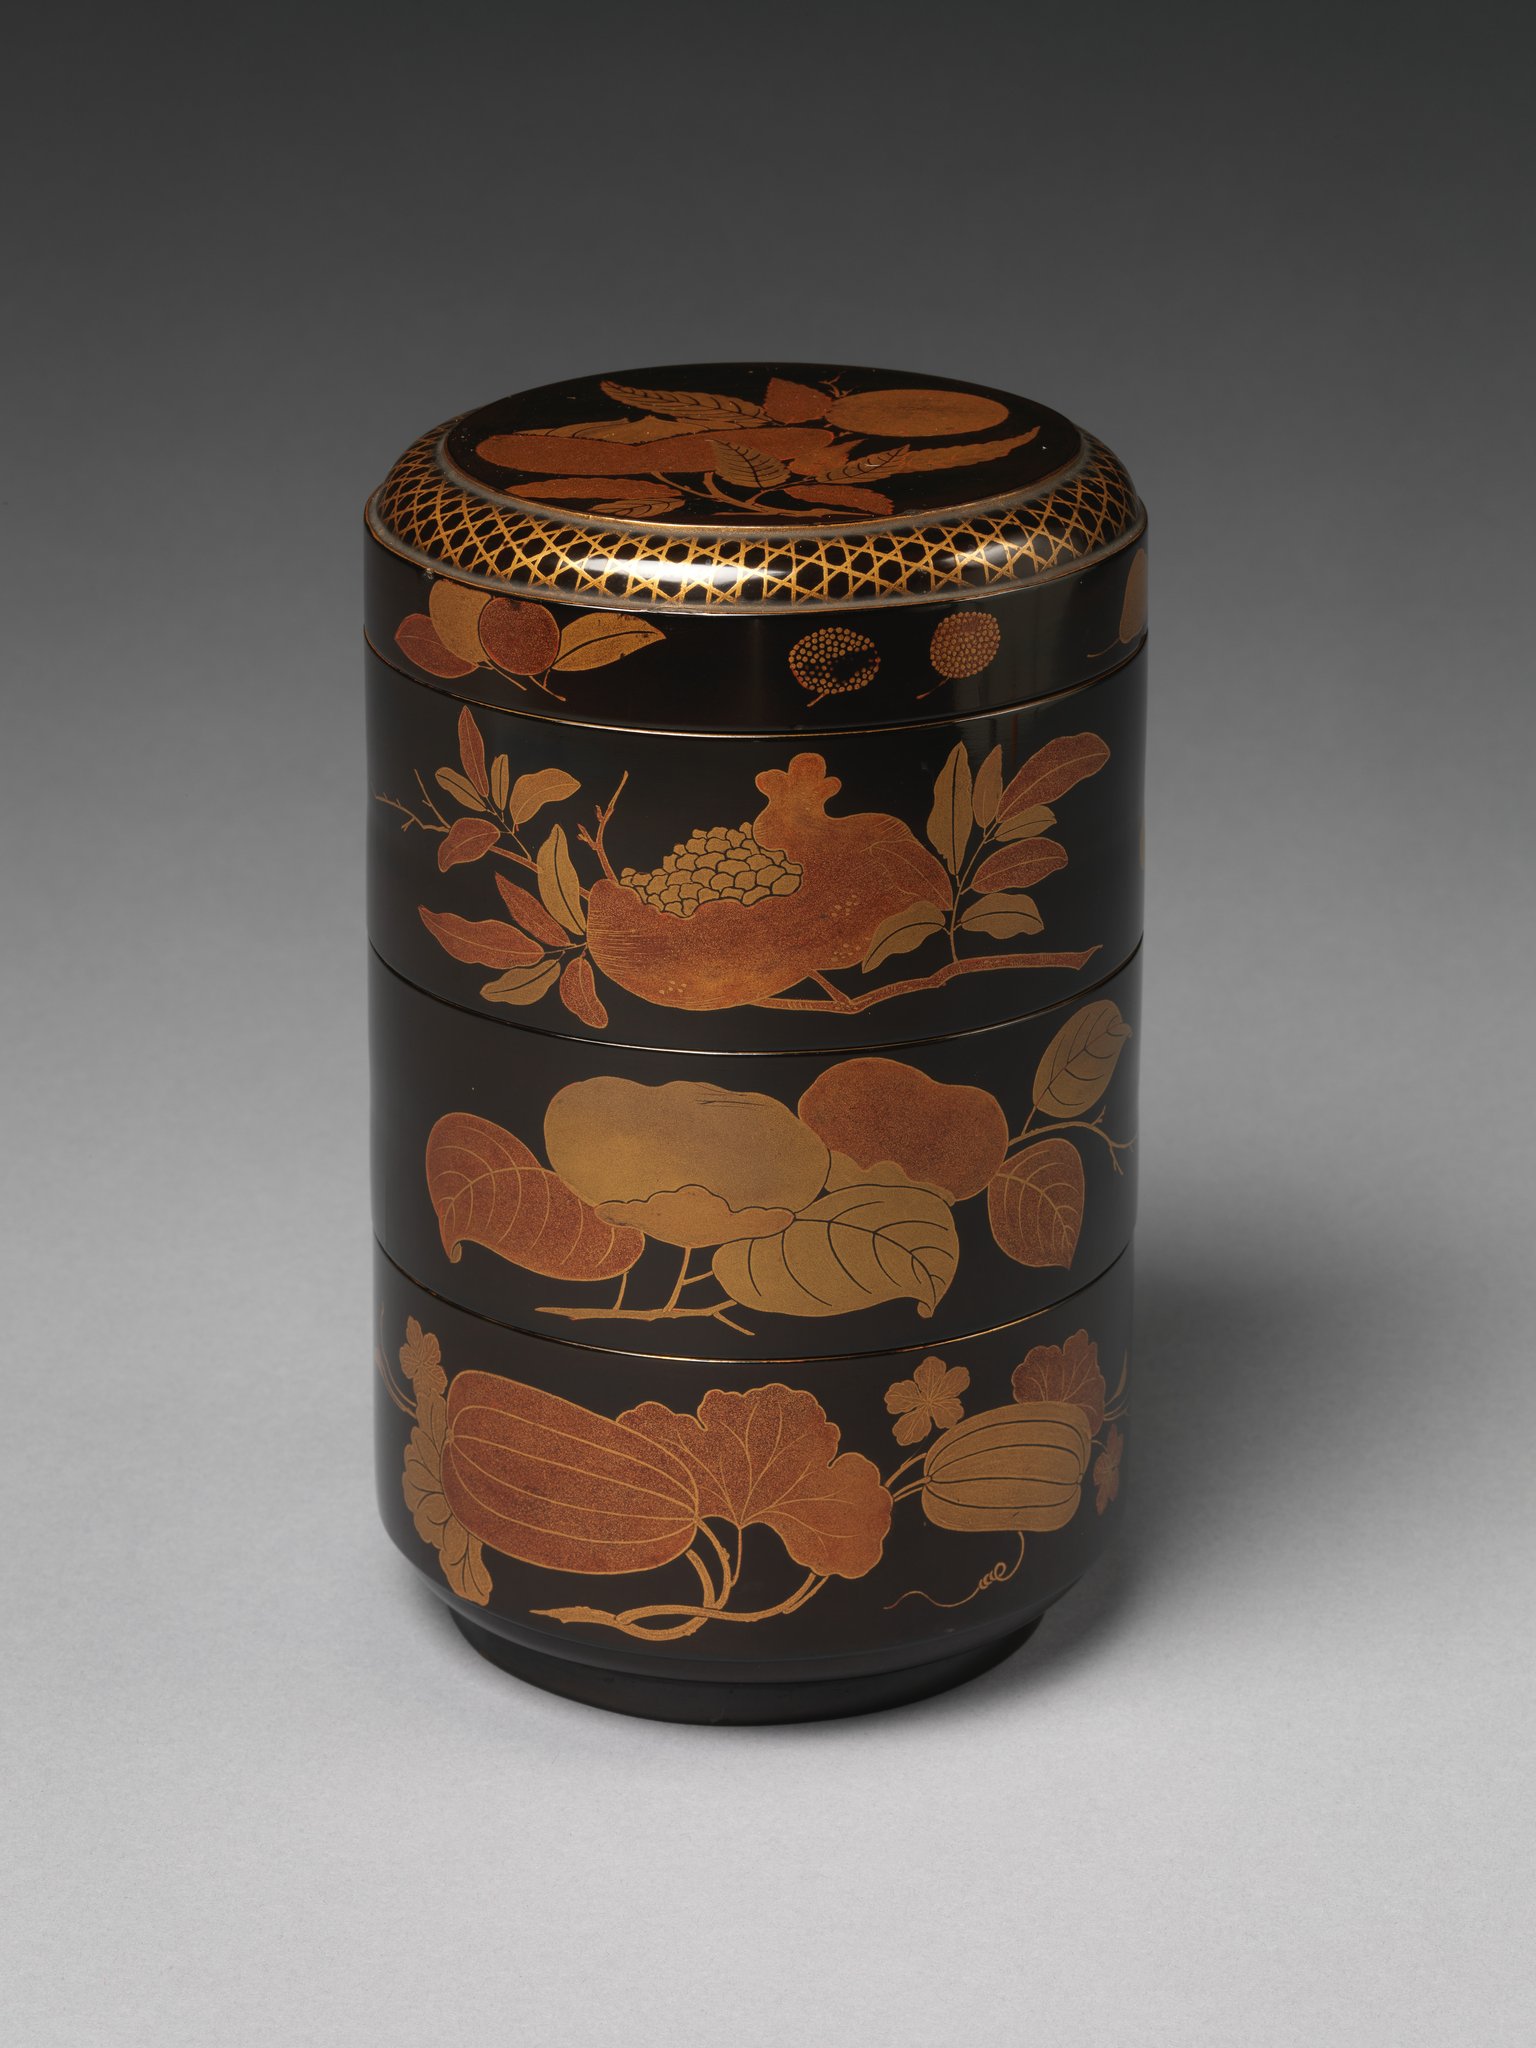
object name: food box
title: Cylindrical Stack of Food Boxes with Decoration of Autumn Fruits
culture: japanese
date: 1601-1700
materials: gold, lacquer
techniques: maki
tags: fruit